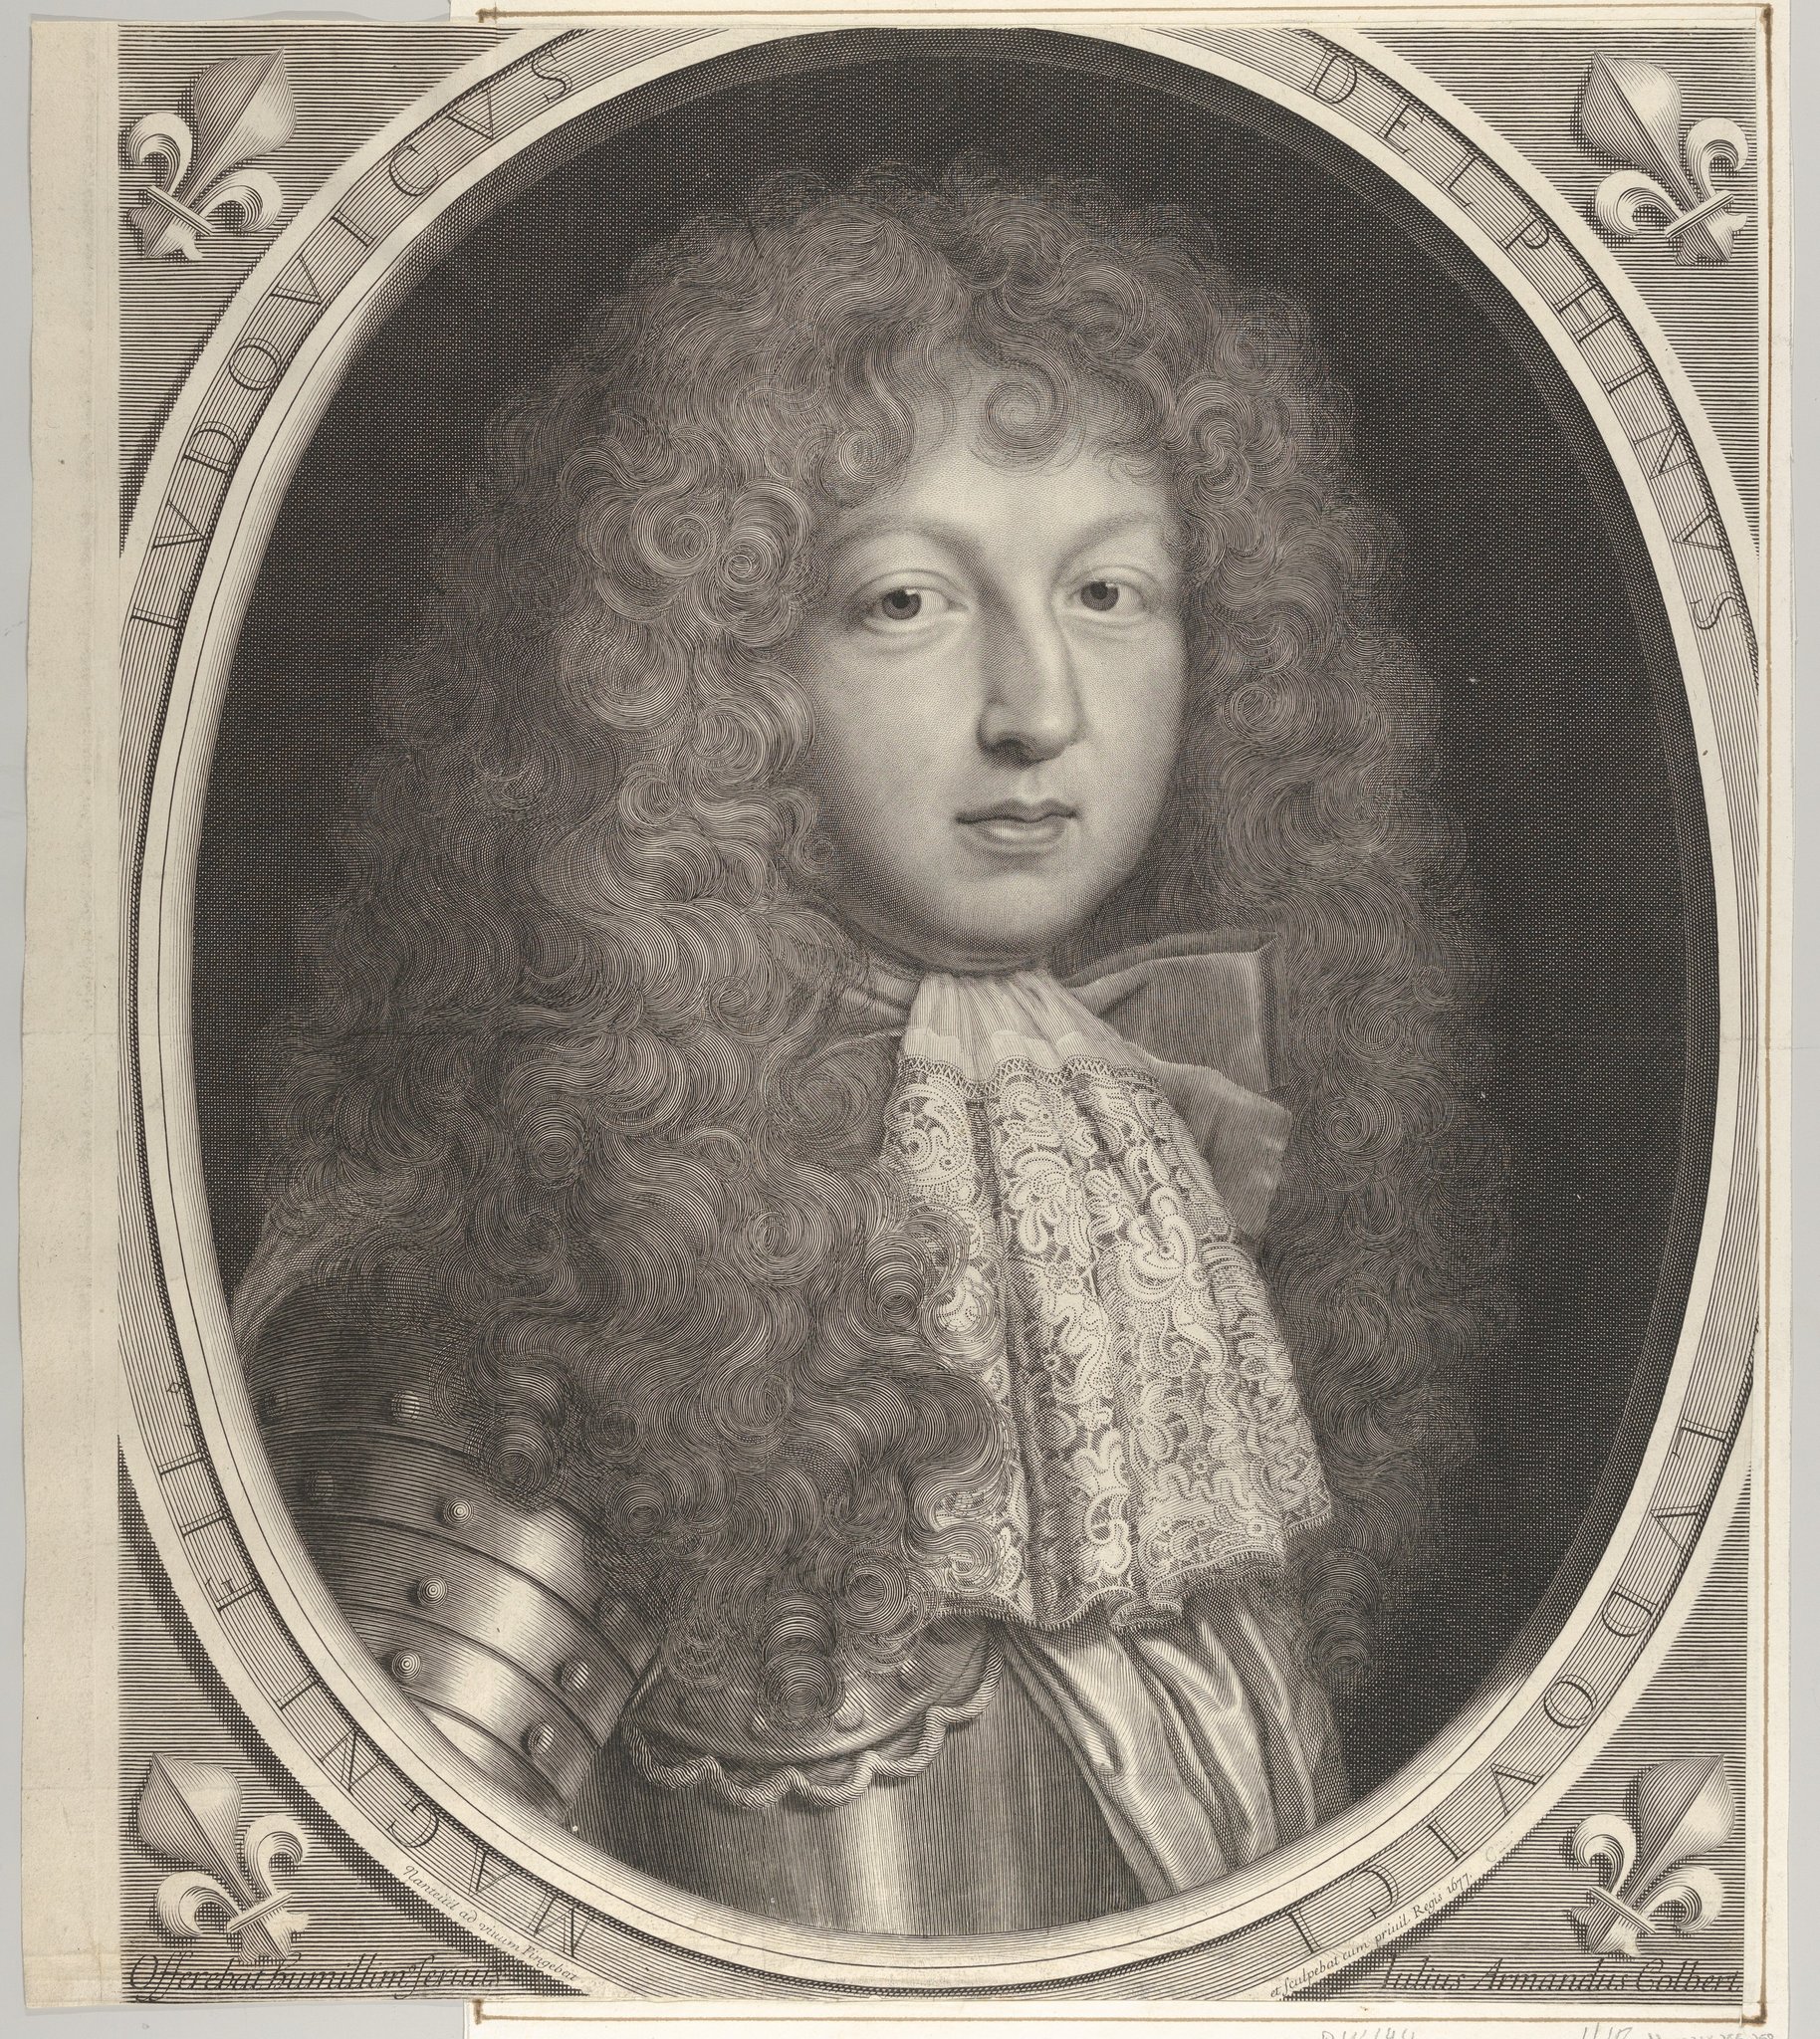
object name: print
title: Louis de France, called Le Grand Dauphin or Monseigneur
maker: robert nanteuil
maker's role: artist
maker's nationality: french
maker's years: 1623-1678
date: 1677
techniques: engraving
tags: men,portraits